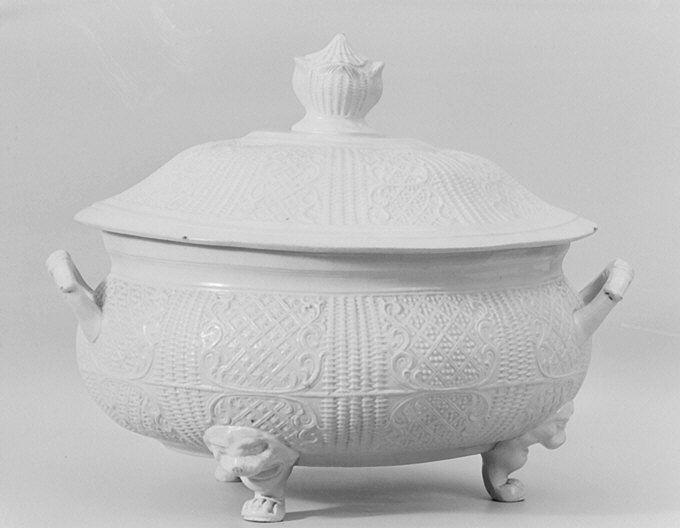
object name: soup tureen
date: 1760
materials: stoneware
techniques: salt glaze